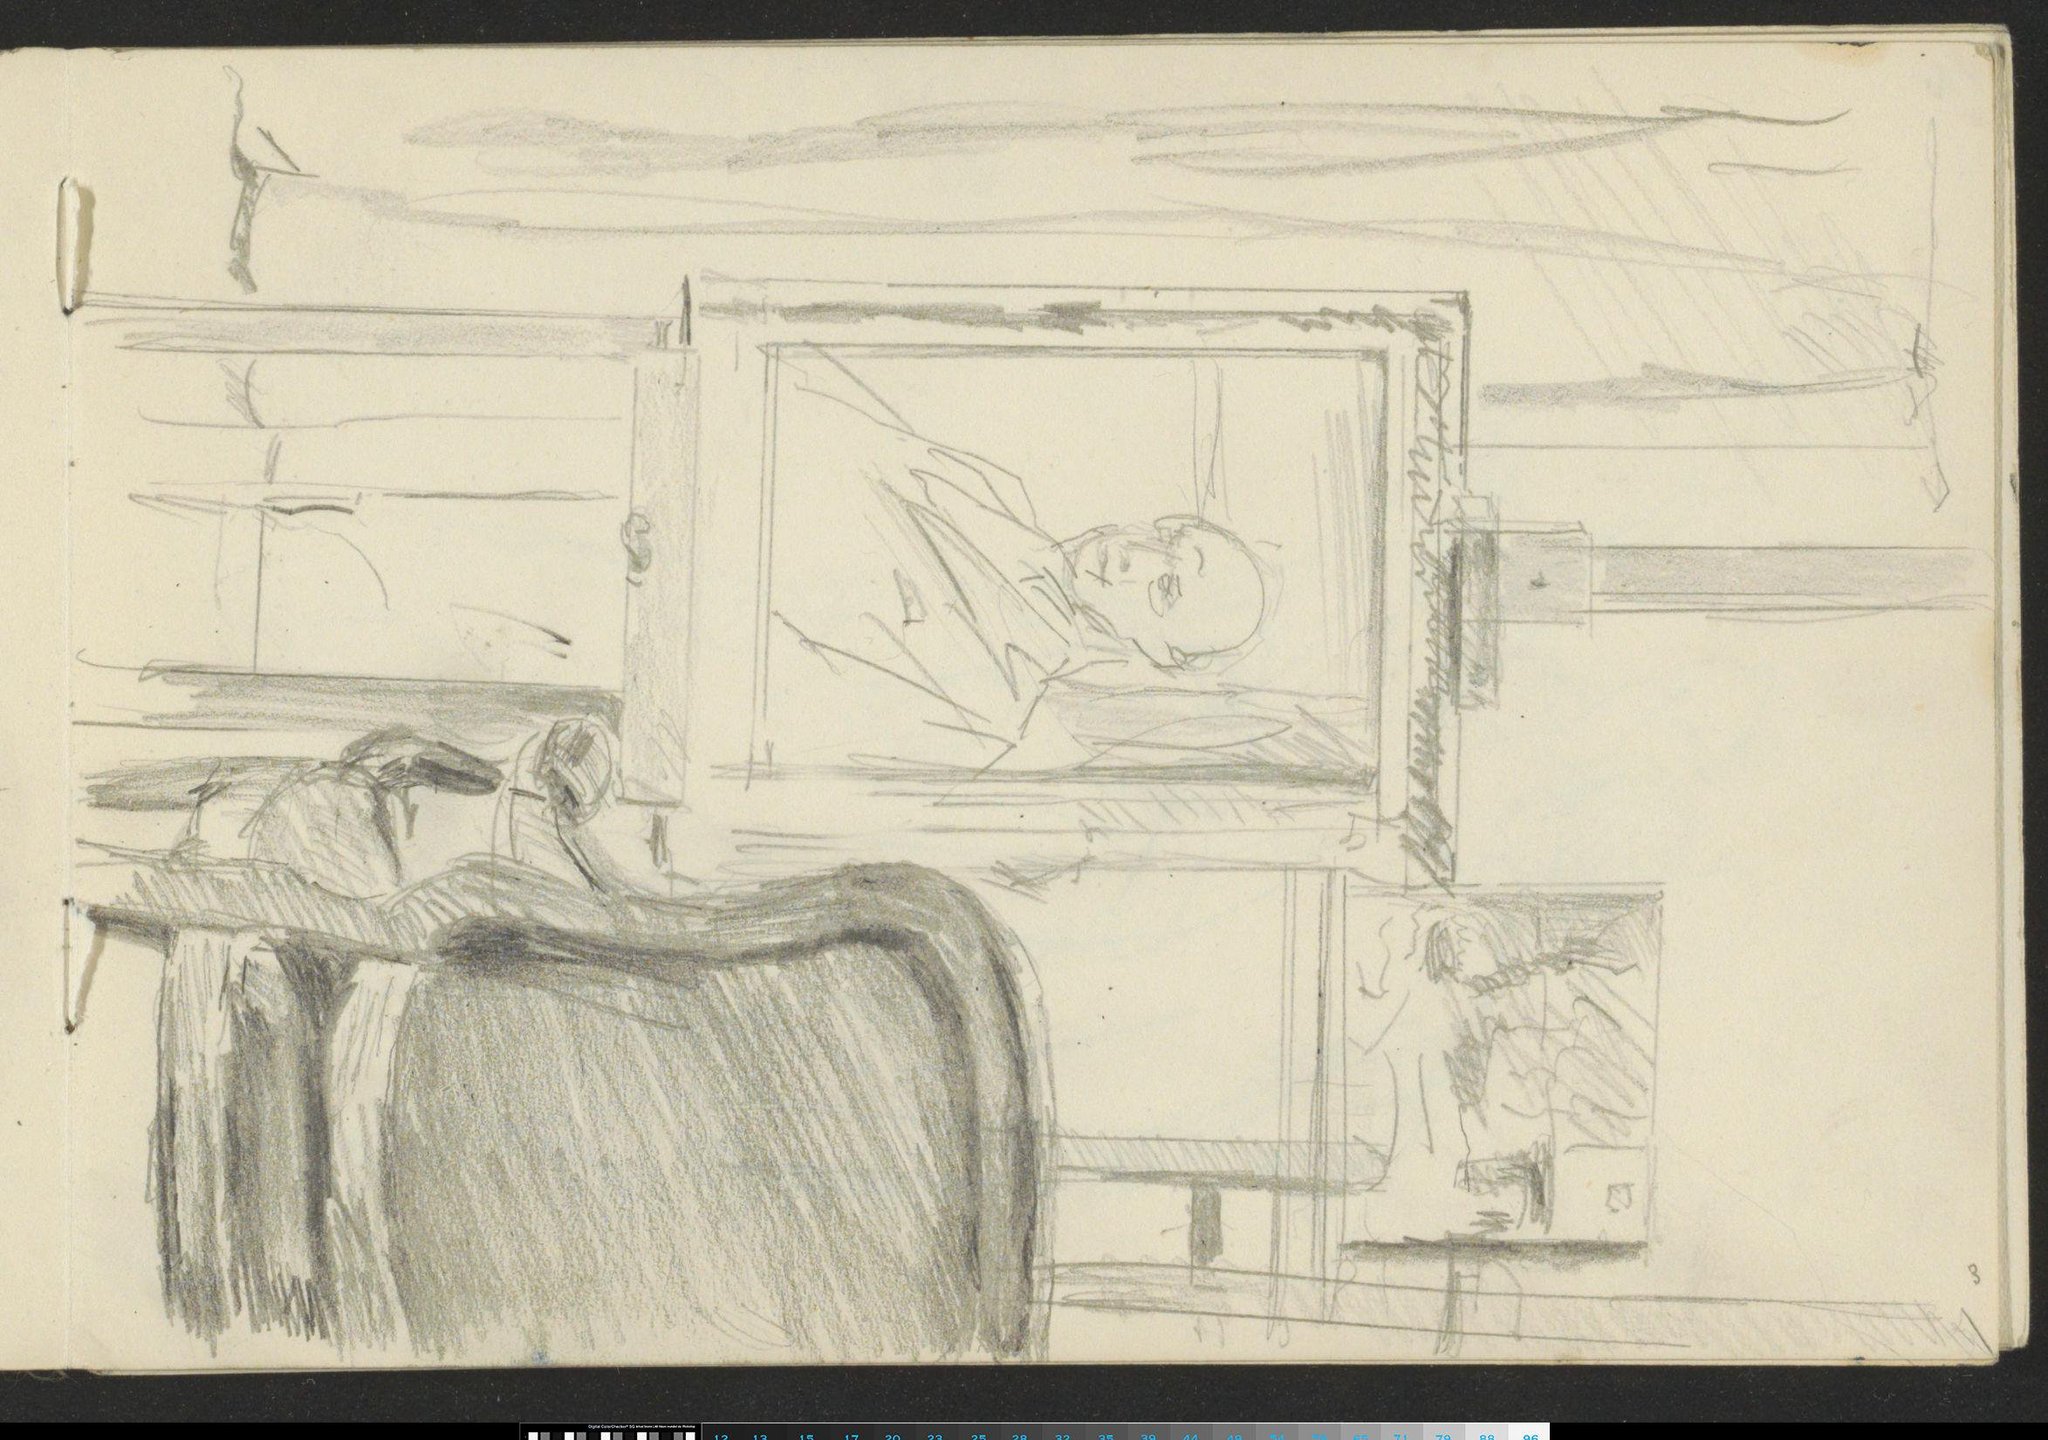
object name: sketchbook leaf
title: Schilderij op een ezel voor een stoel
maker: isaac israels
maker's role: draughtsman, painter, print maker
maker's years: 1865-1934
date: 1875-1934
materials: paper, pencil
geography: the hague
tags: easel, picture, painting, chair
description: Portret van een onbekende man. Op de achtergrond nog een schilderij. Blad 3 recto uit schetsboek LXI met 20 bladen.